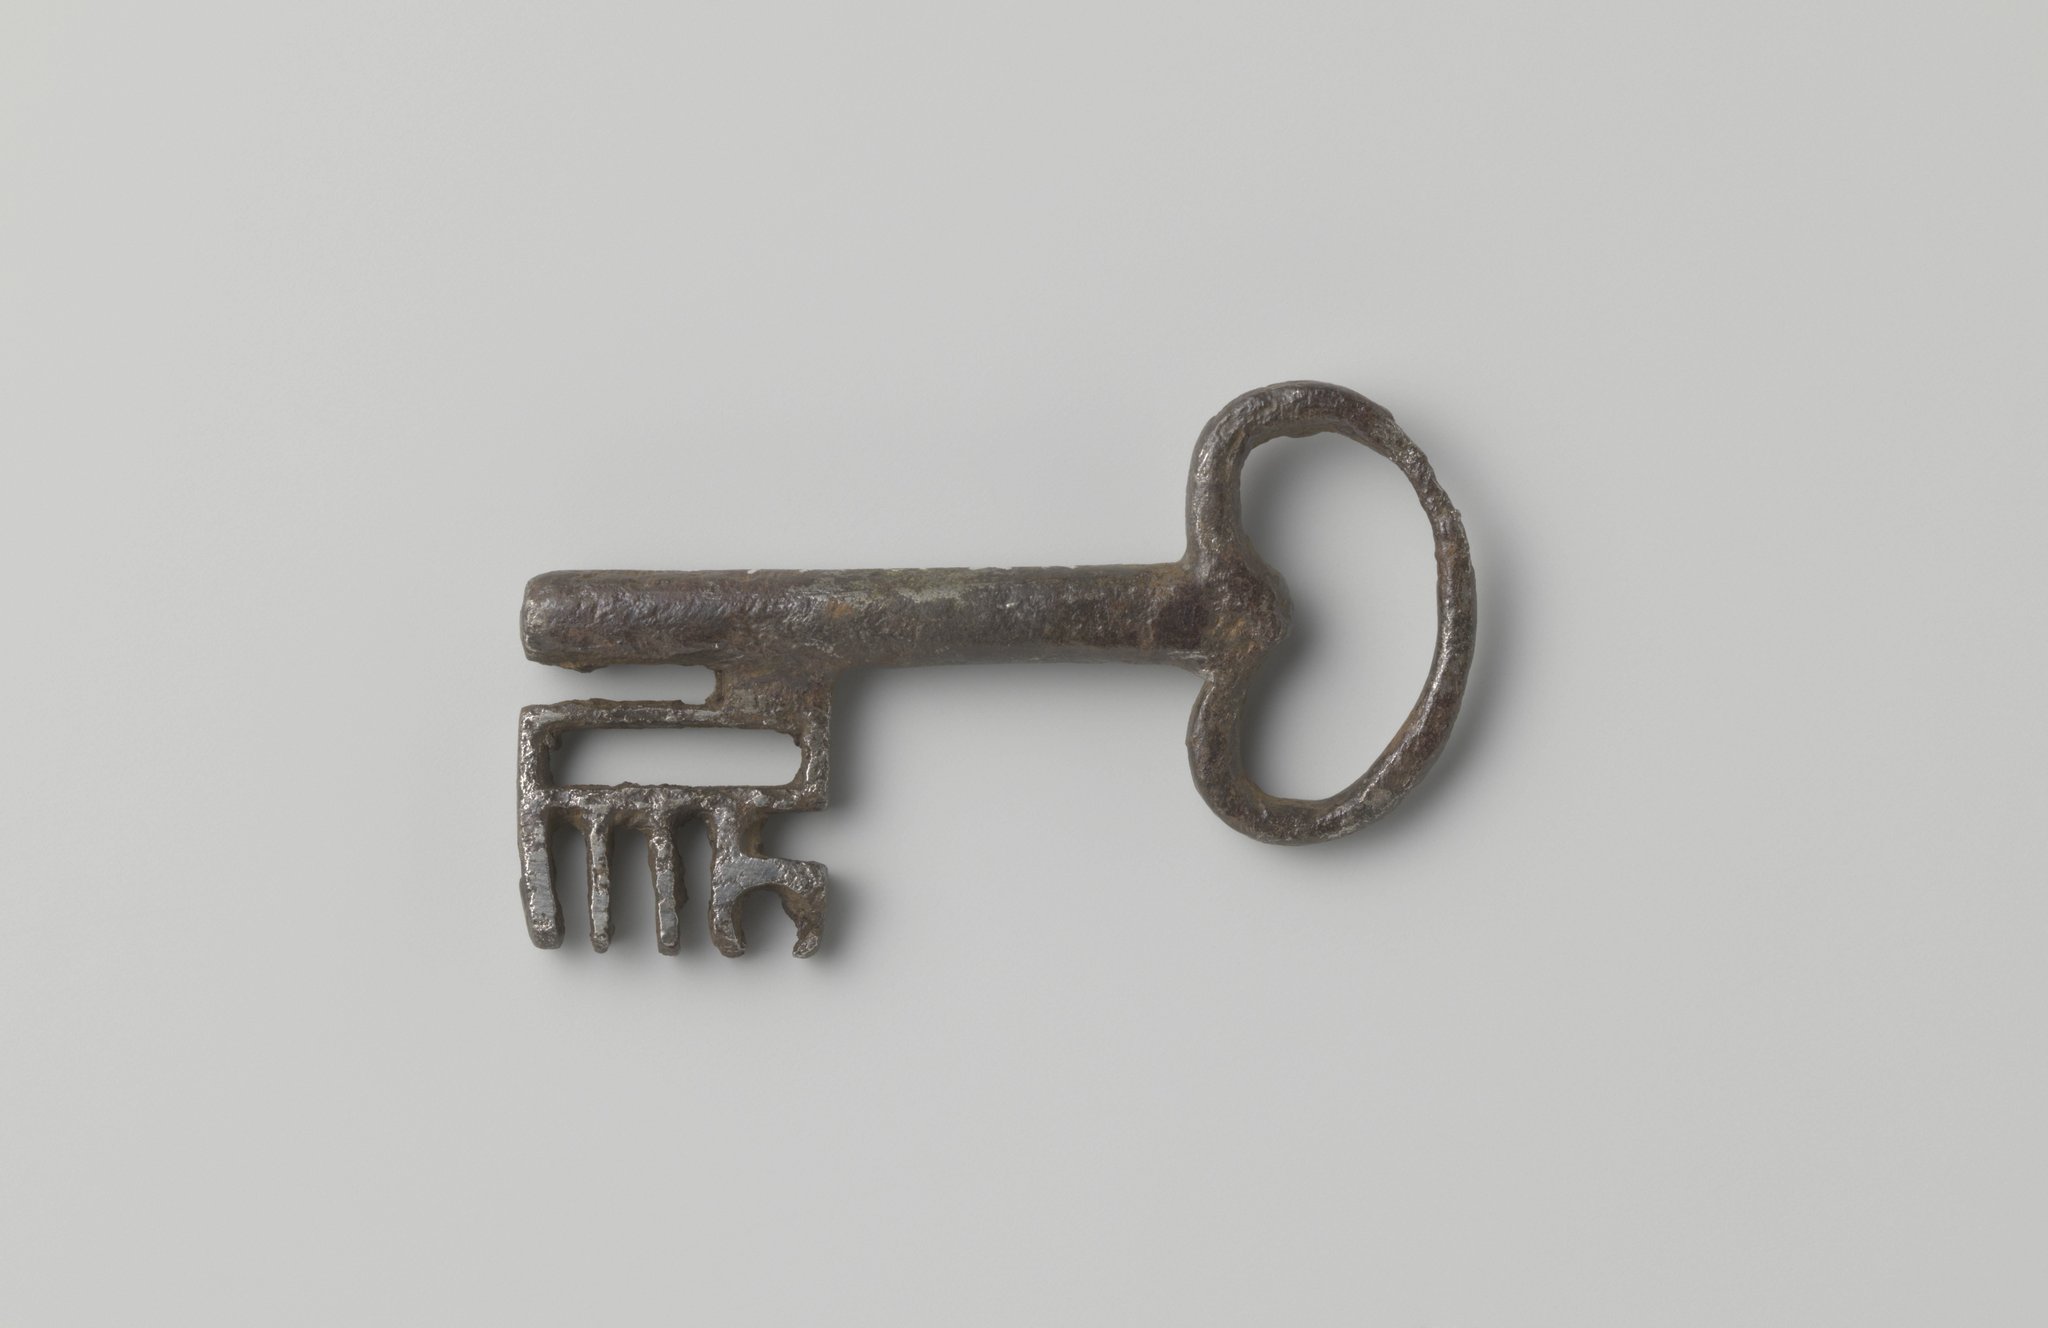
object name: socket wrench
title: Dopsleutel van staal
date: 1400-1500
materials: steel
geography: france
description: Stalen dopsleutel met gedetailleerde en opengetande baard, ring boonvormig gebogen.